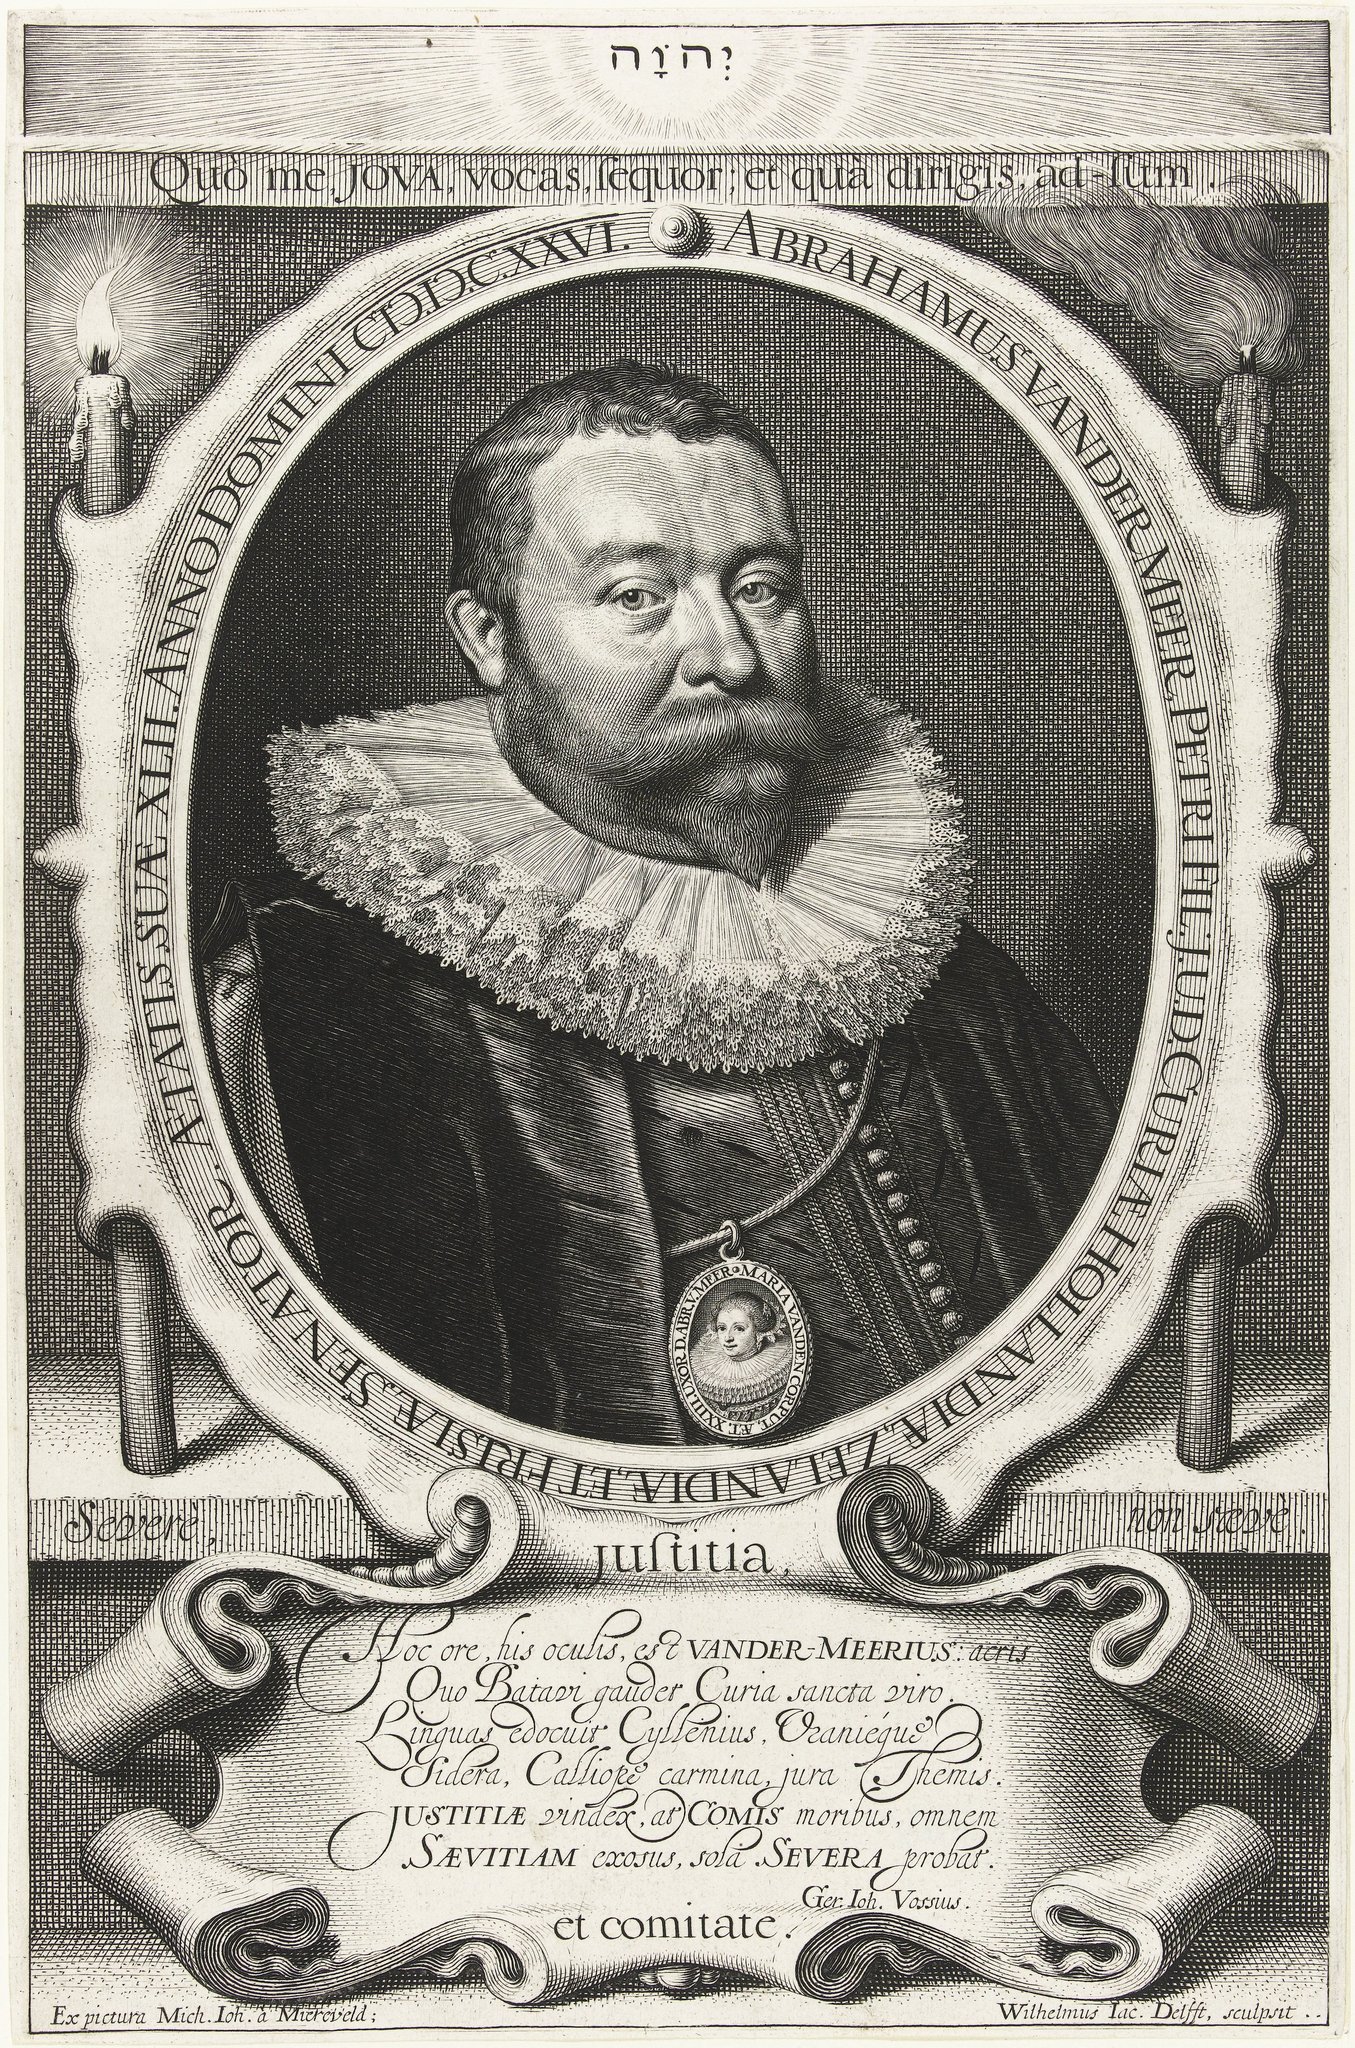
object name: print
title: Portret van Abraham van der Meer op 42-jarige leeftijd met portret miniatuur van zijn vrouw Maria van den Corput op 23-jarige leeftijd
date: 1626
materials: paper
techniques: engraving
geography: delft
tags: 'vanitas' symbols, tetragram (in roman or hebrew script) ~ symbol of god the father, neck-gear: collar (+ men's clothes)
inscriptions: collector's mark: Lugt 240, inscription: ‘RQ’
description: Portret van raadsheer Abraham van der Meer op 42-jarige leeftijd, hij draagt een medaillon met portret miniatuur van zijn vrouw Maria van den Corput op 23-jarige leeftijd aan een ketting. Borststuk gekleed in plooikraag en toga in ovale cartouche geflankeerd door een brandende en een gedoofde kaars. Onder het portret een cartouche met Latijns vers in zes regels. Boven het portret is met een aparte smalle plaat de Hebreeuwse naam van God in stralend licht gedrukt. De stralen lopen door in de bovenrand van de plaat met het portret.